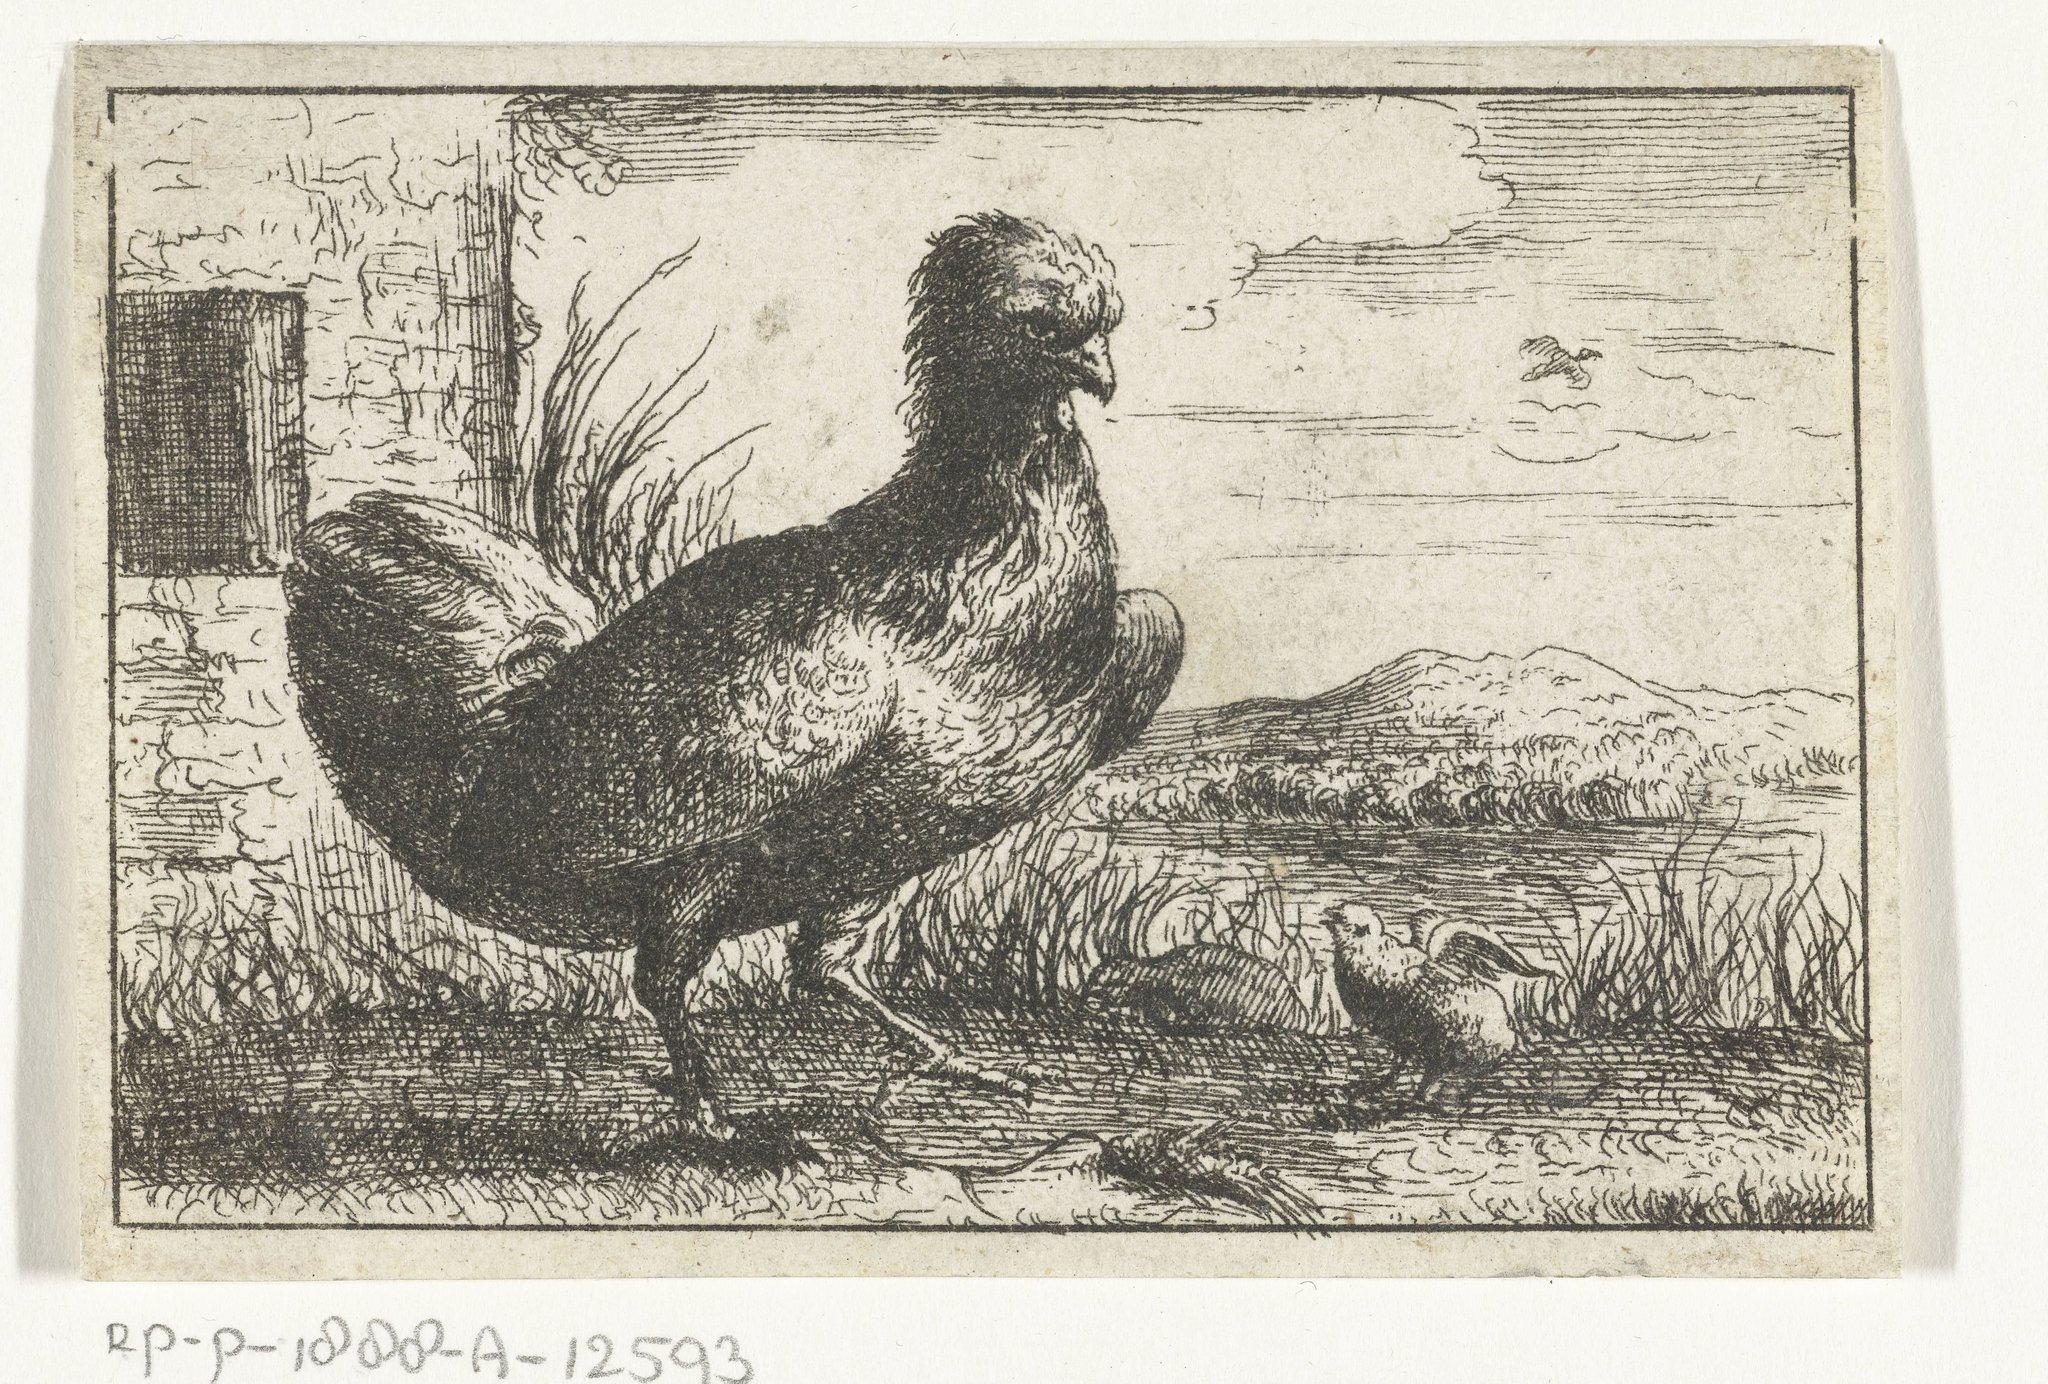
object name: print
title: Kip met kuiken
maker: Anonymous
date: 1659-1741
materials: paper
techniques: etching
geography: paris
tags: fowl (cock, hen, chicken, etc.)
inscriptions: collector's mark: Lugt 2228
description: Kopie in spiegelbeeld naar een prent uit de serie Dertien vogelsoorten van Albert Flamen.